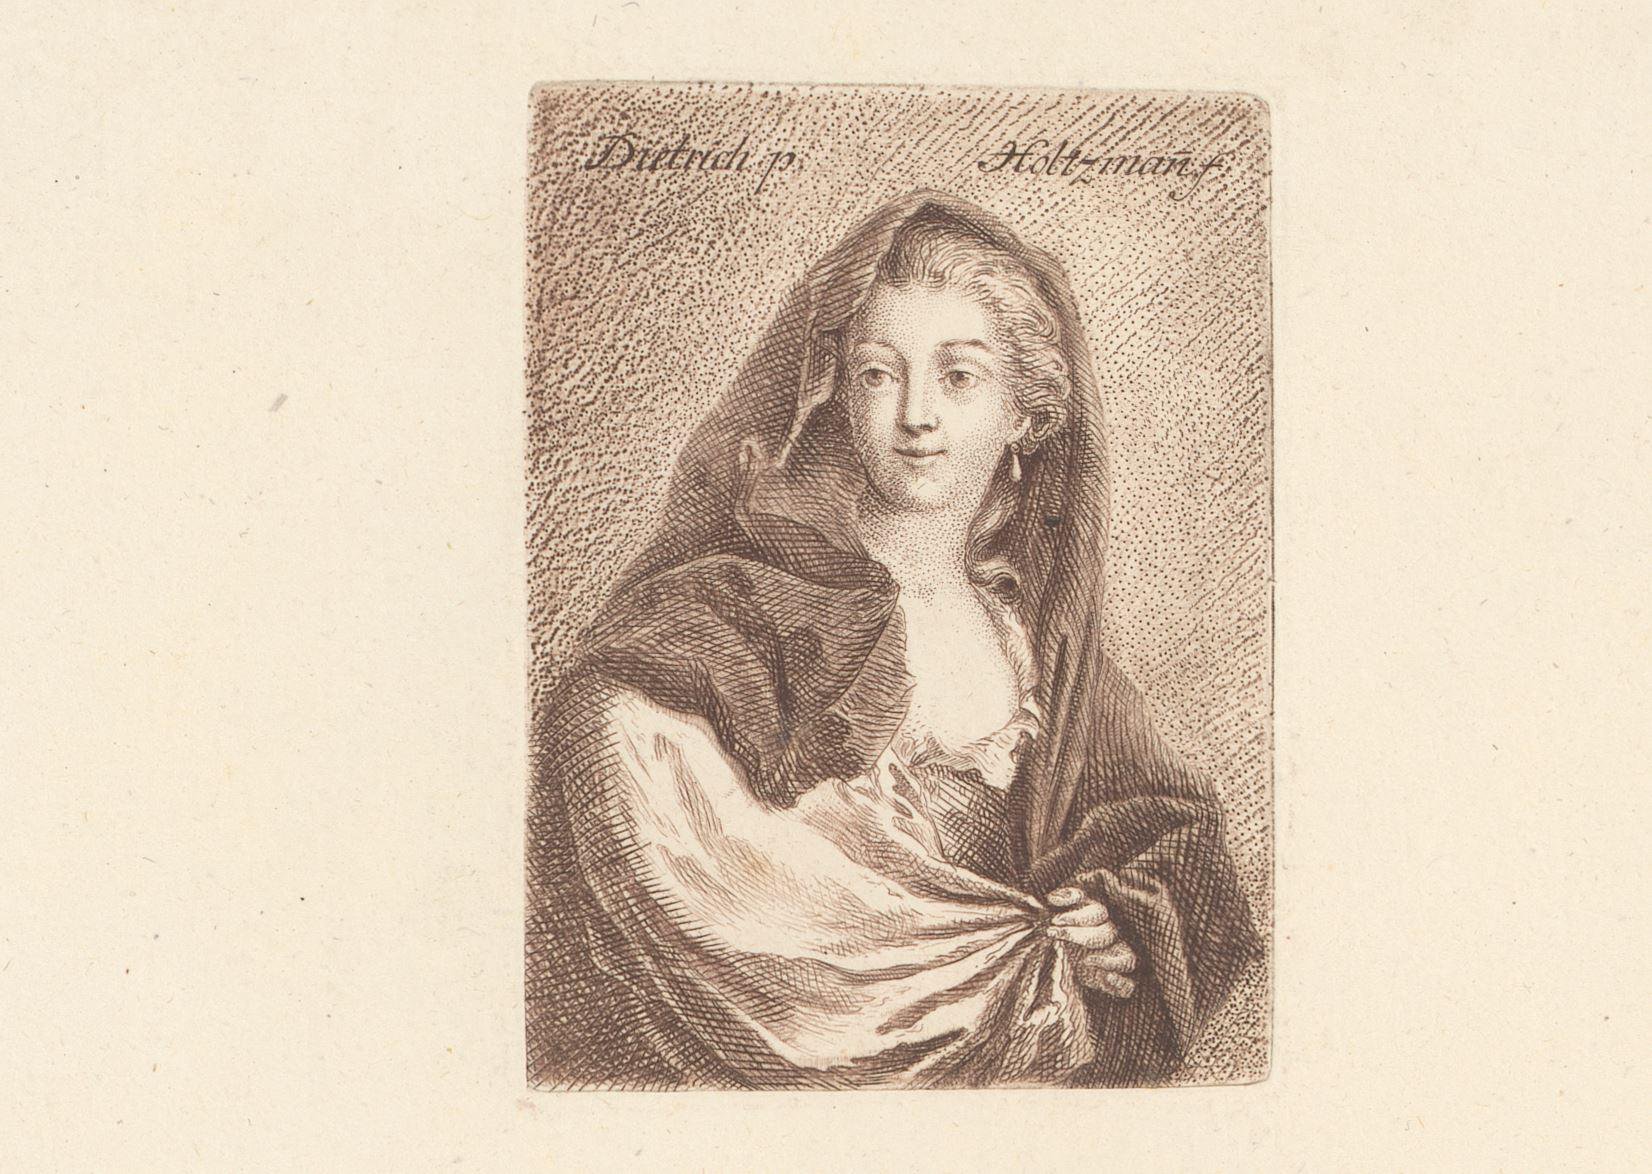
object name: print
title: Portret van een onbekende gesluierde vrouw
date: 1750-1811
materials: paper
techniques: etching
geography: dresden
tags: anonymous historical person portrayed, veil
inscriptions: collector's mark: Lugt 2760, collector's mark: Lugt 2228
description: Tekst in het Duits in de ondermarge. Prent maakt deel uit van een album.